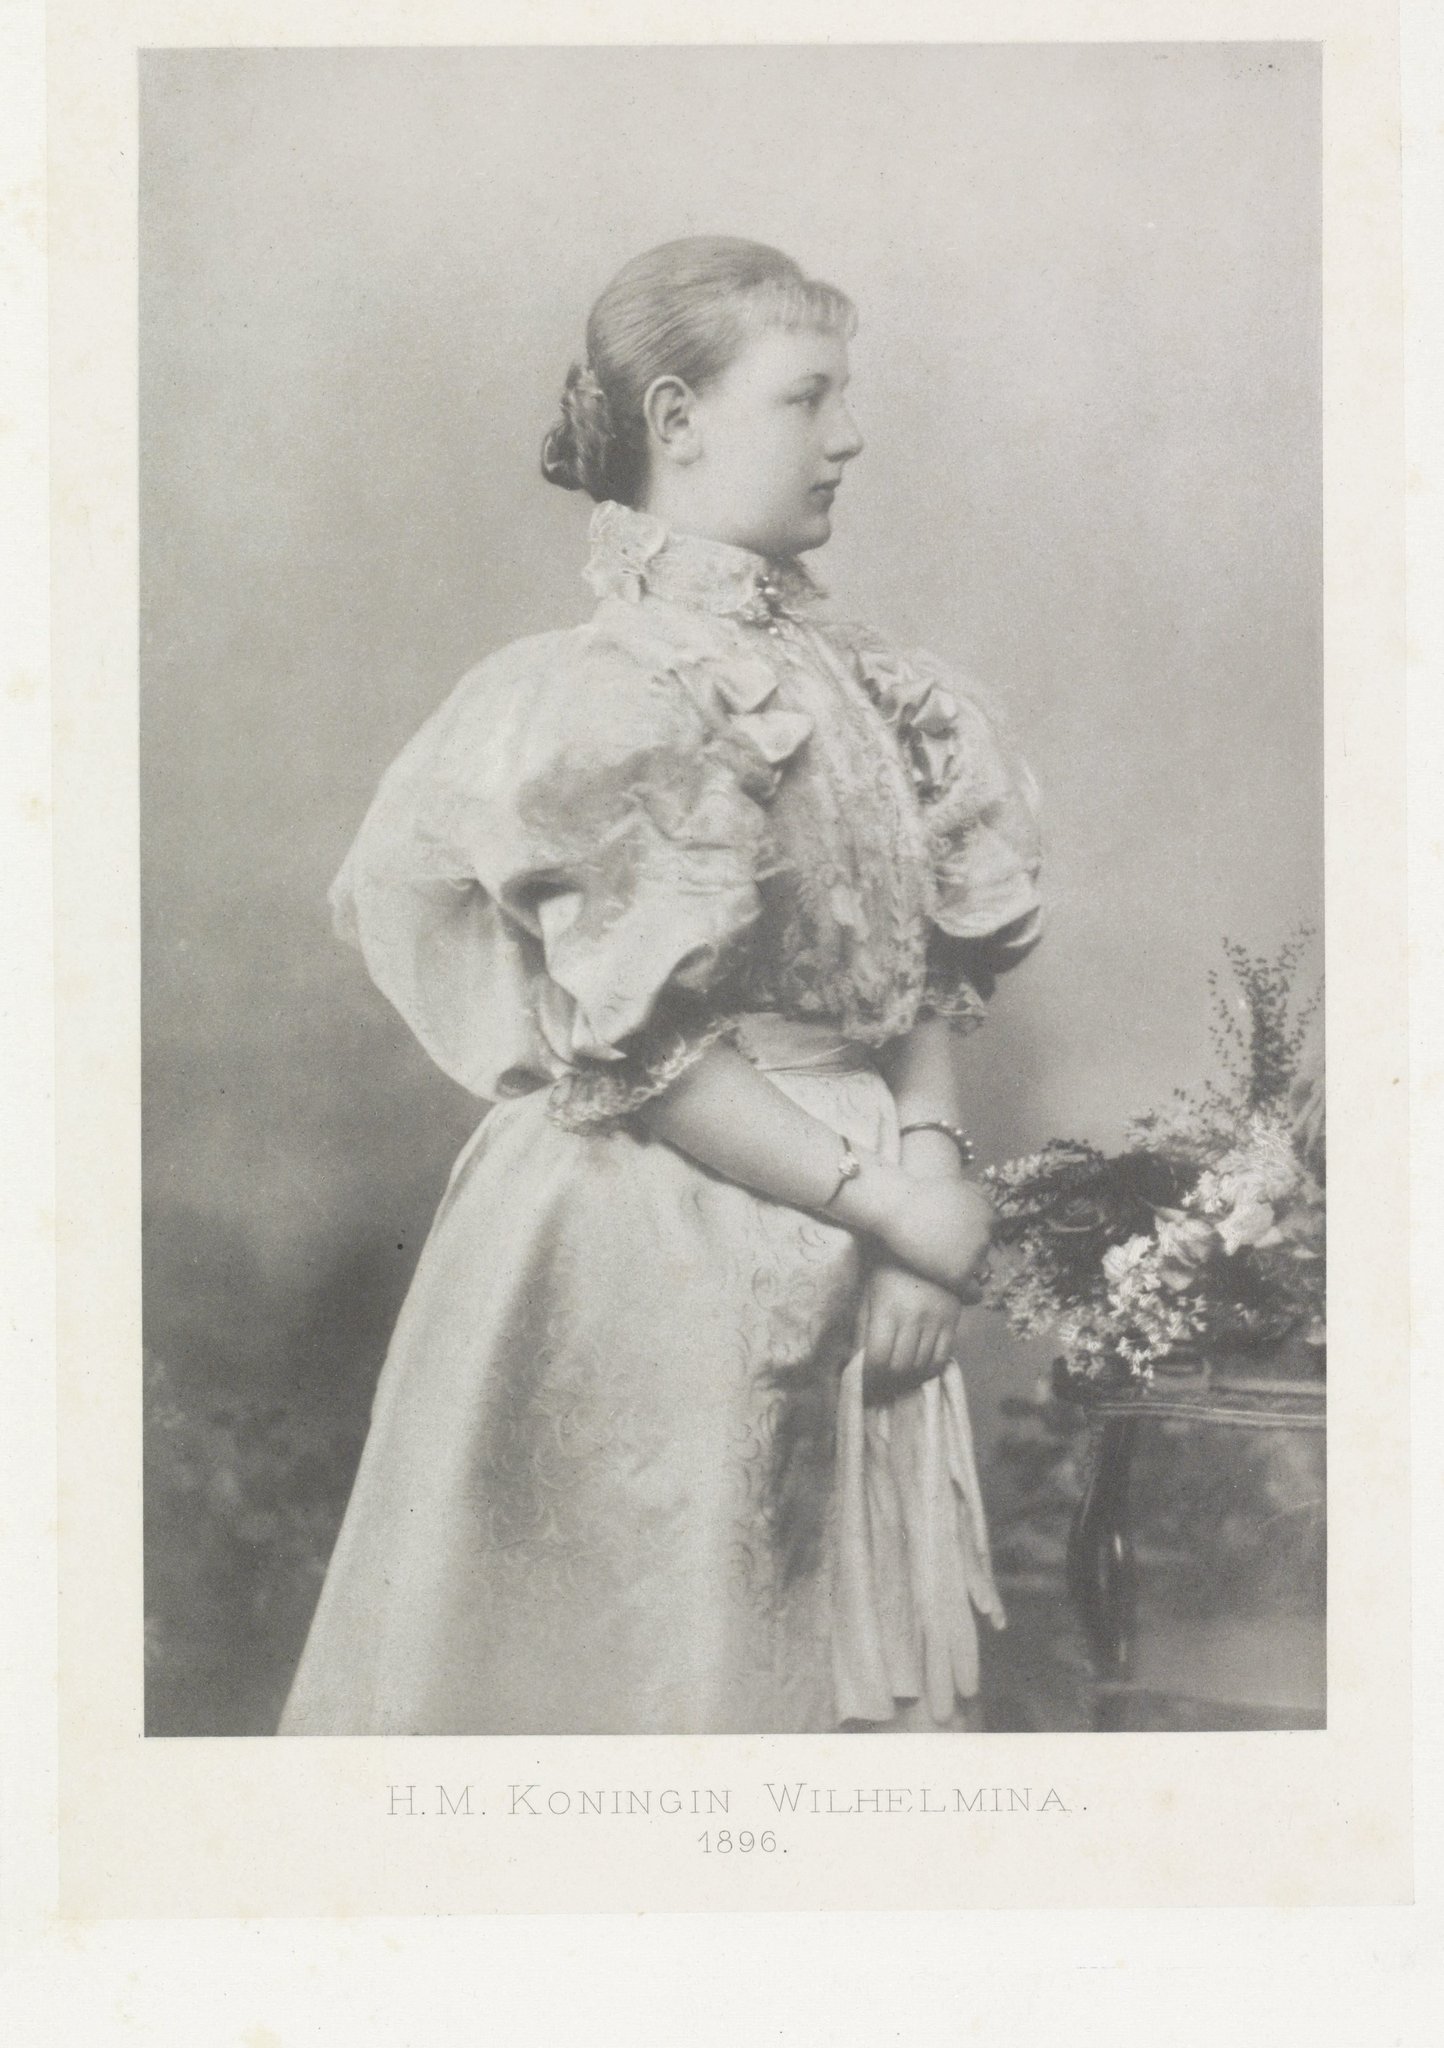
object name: photomechanical print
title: Portret van Wilhelmina, koningin der Nederlanden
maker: richard kameke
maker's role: fotograaf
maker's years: 1847-1898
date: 1896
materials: paper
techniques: photoaquatint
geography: berlin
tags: the hague, print maker, wilhelmina of the netherlands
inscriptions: date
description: De hier vermelde titel verwijst naar de hoogst verkregen titel van de geportretteerde, niet per se naar de titel die de geportretteerde op deze voorstelling draagt.